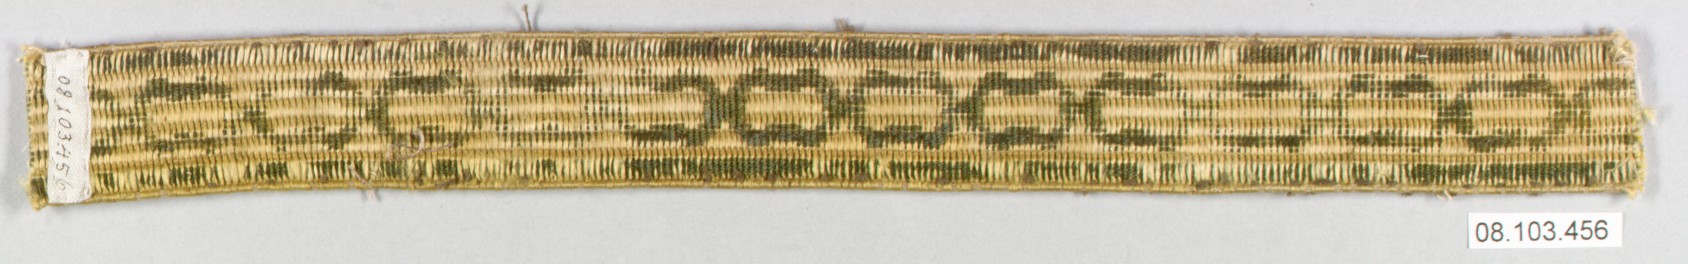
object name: galloon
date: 1801-1900